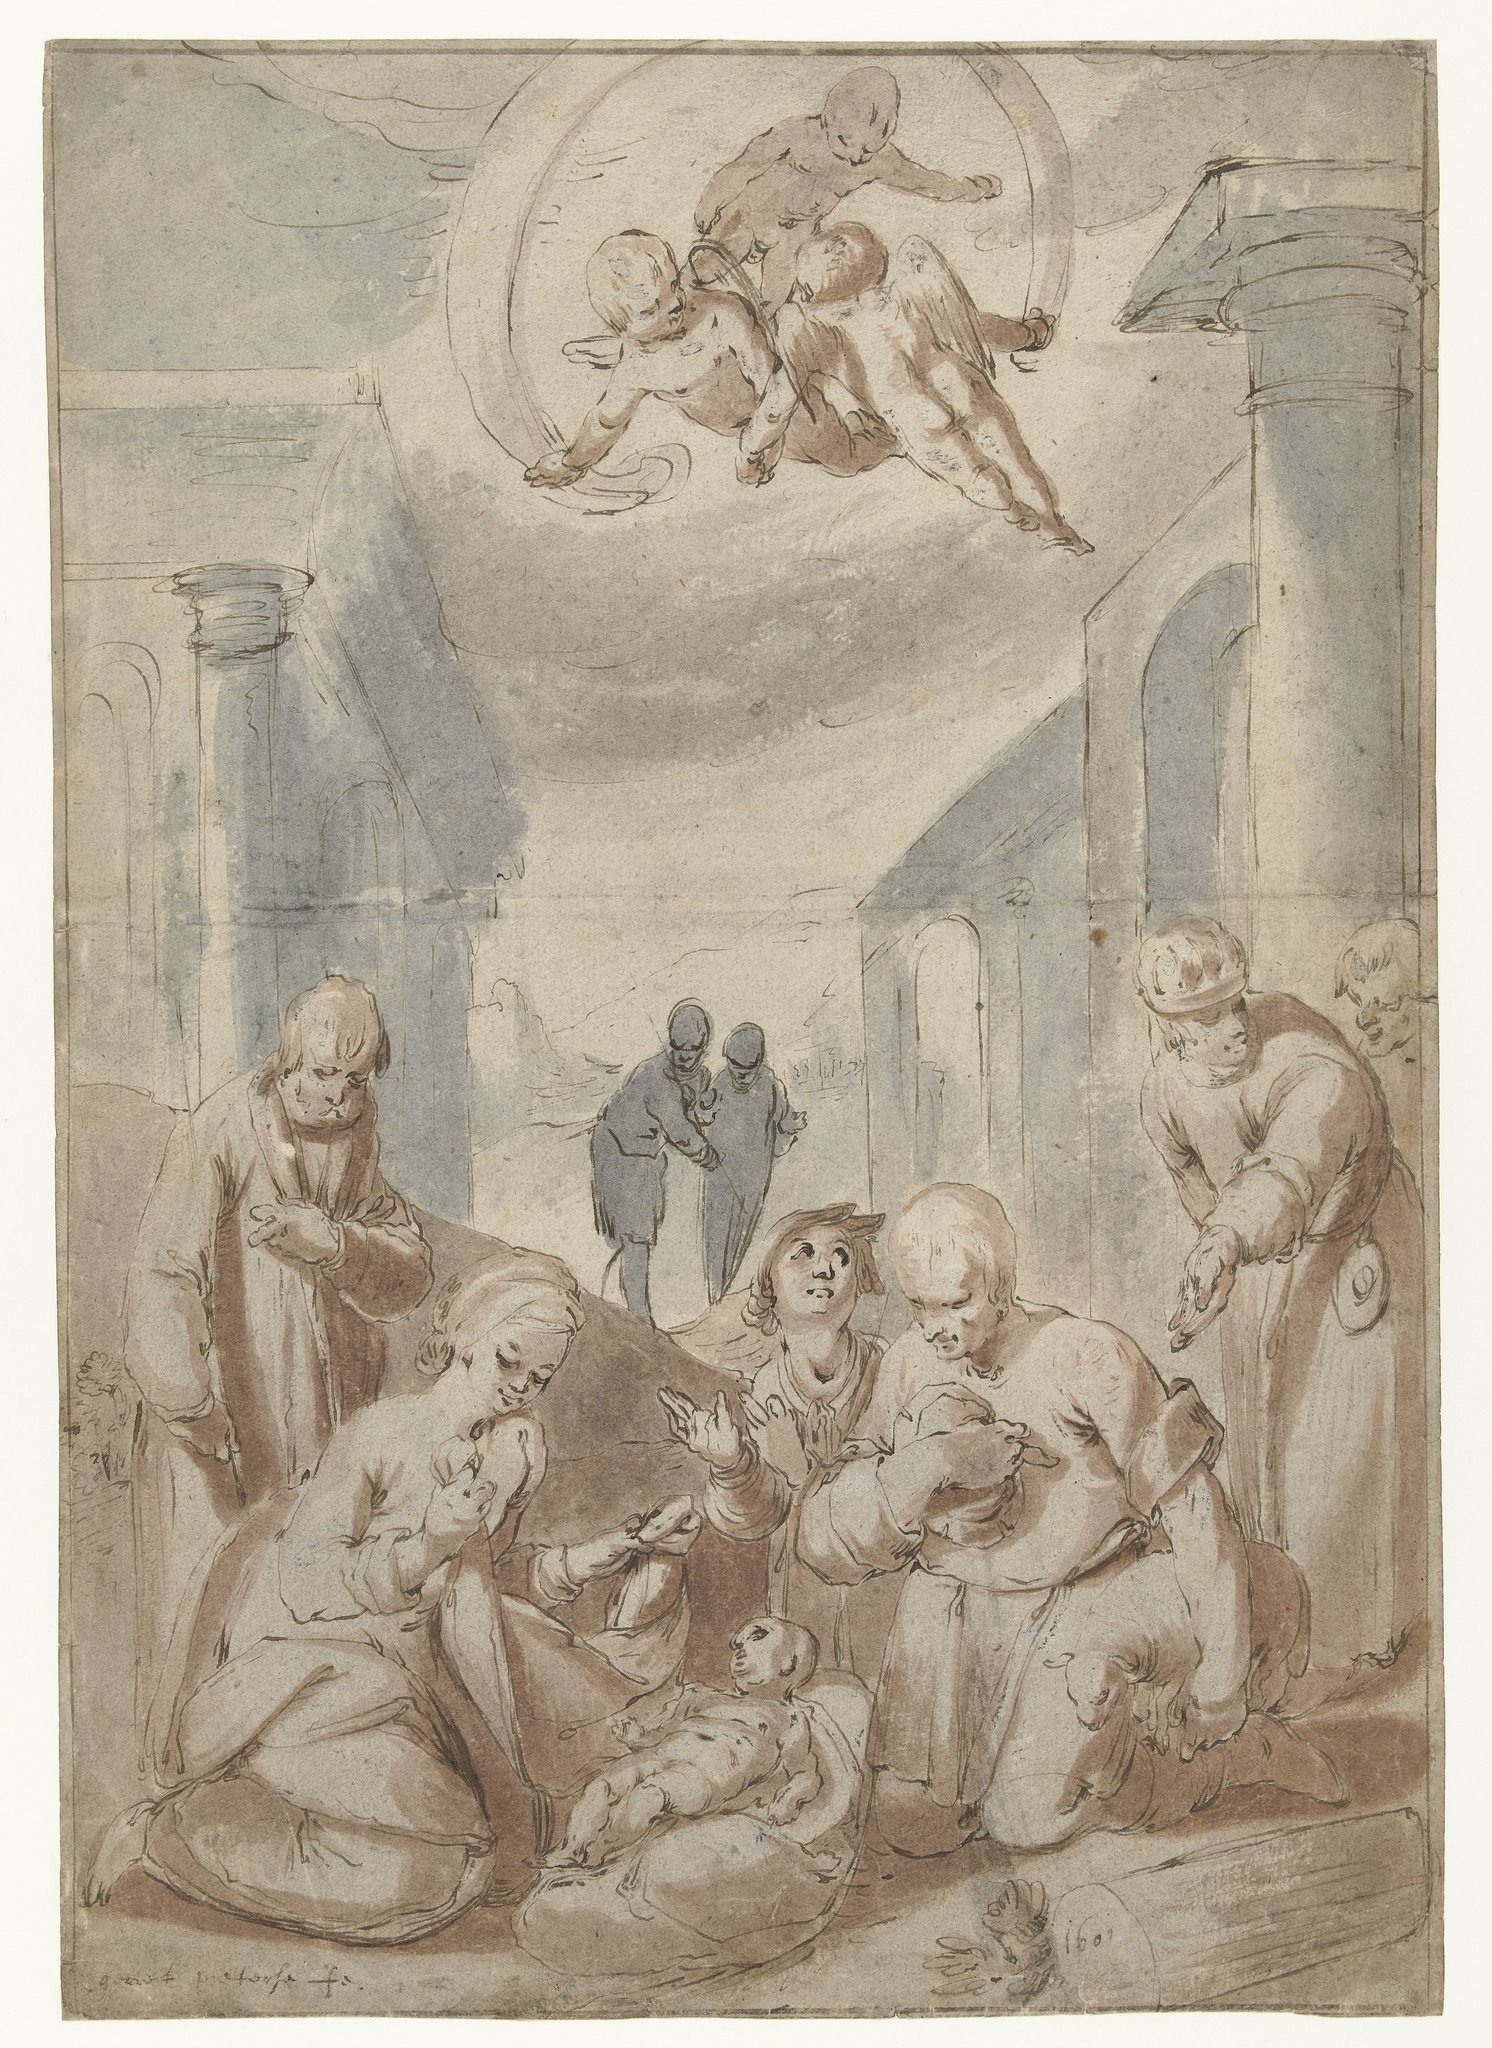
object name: drawing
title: Adoration of the Shepherds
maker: gerrit pietersz. sweelink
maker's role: draughtsman, painter, print maker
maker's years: 1566-1612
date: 1601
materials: ink, paper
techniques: brush, pen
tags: adoration of the christ-child by the shepherds; mary and joseph present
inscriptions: date